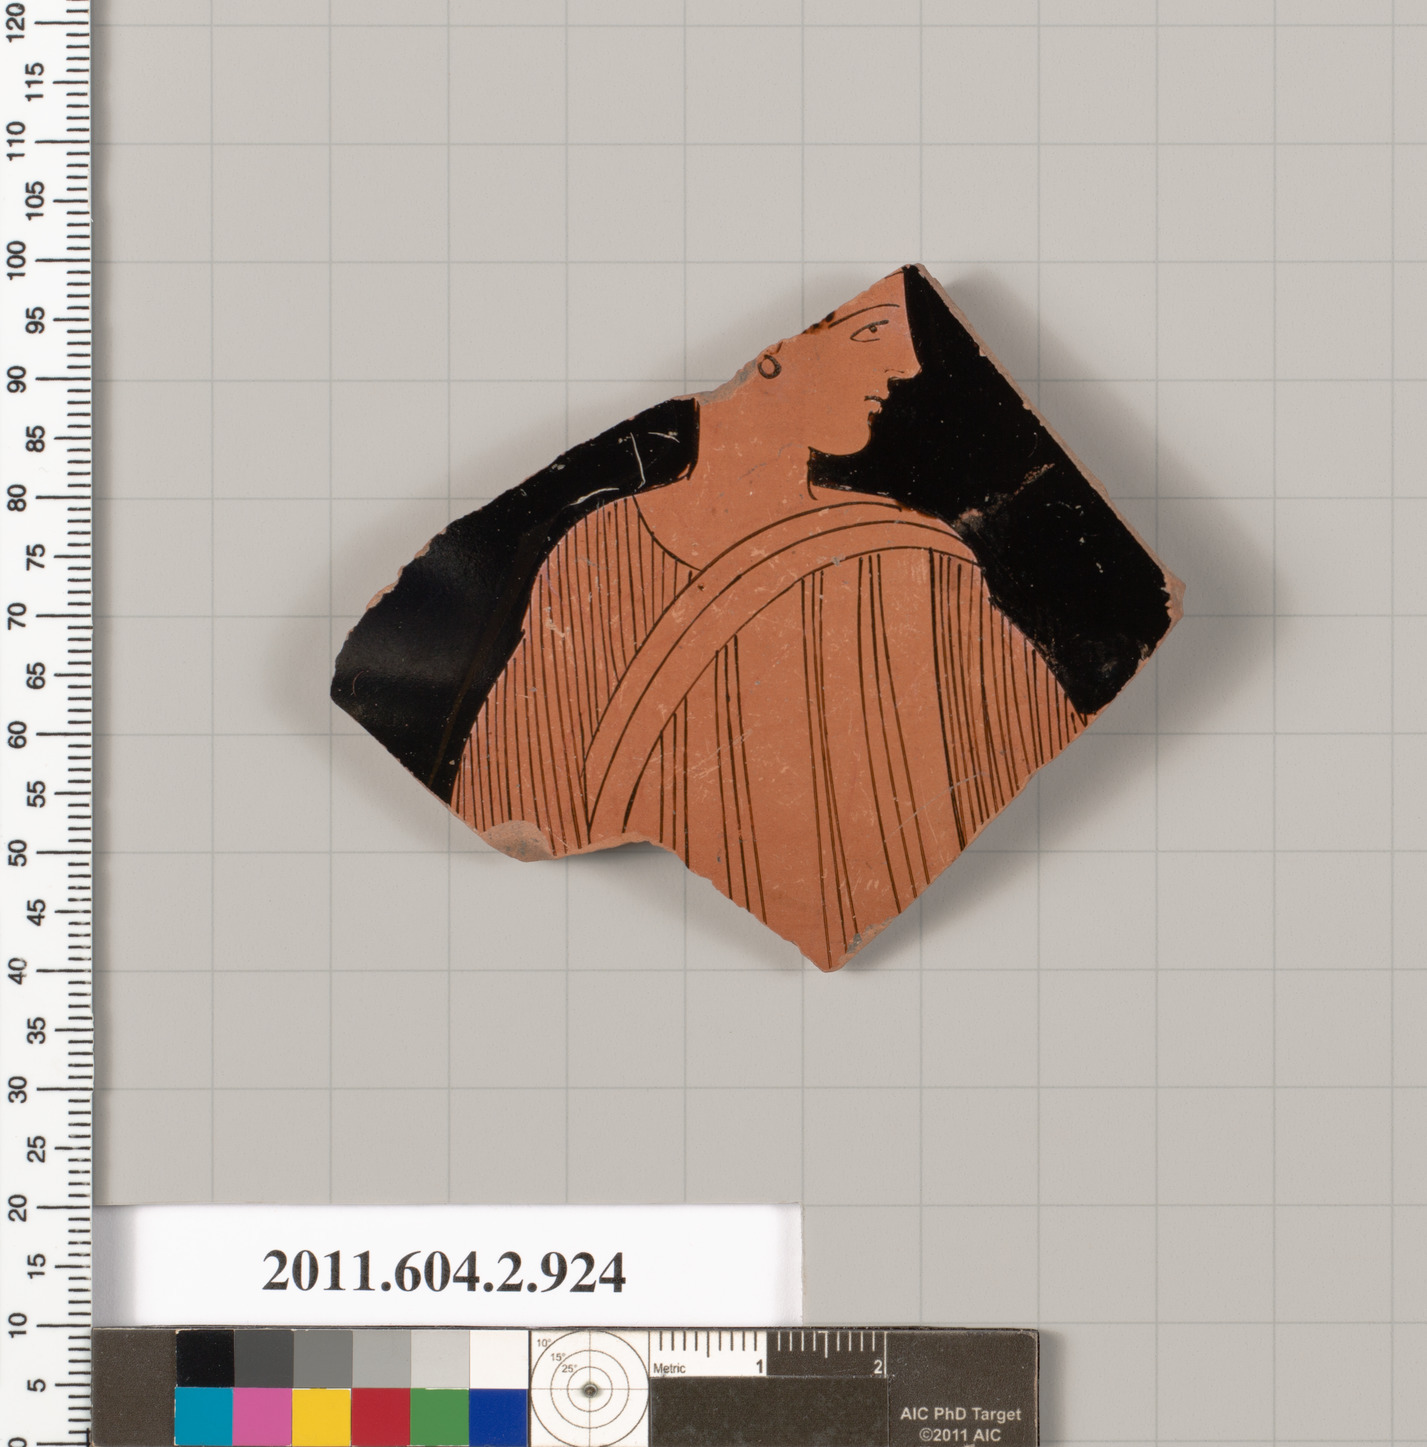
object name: kalpis fragment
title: Terracotta fragment of a hydria: kalpis (water jar)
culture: greek, attic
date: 460-440 BCE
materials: terracotta